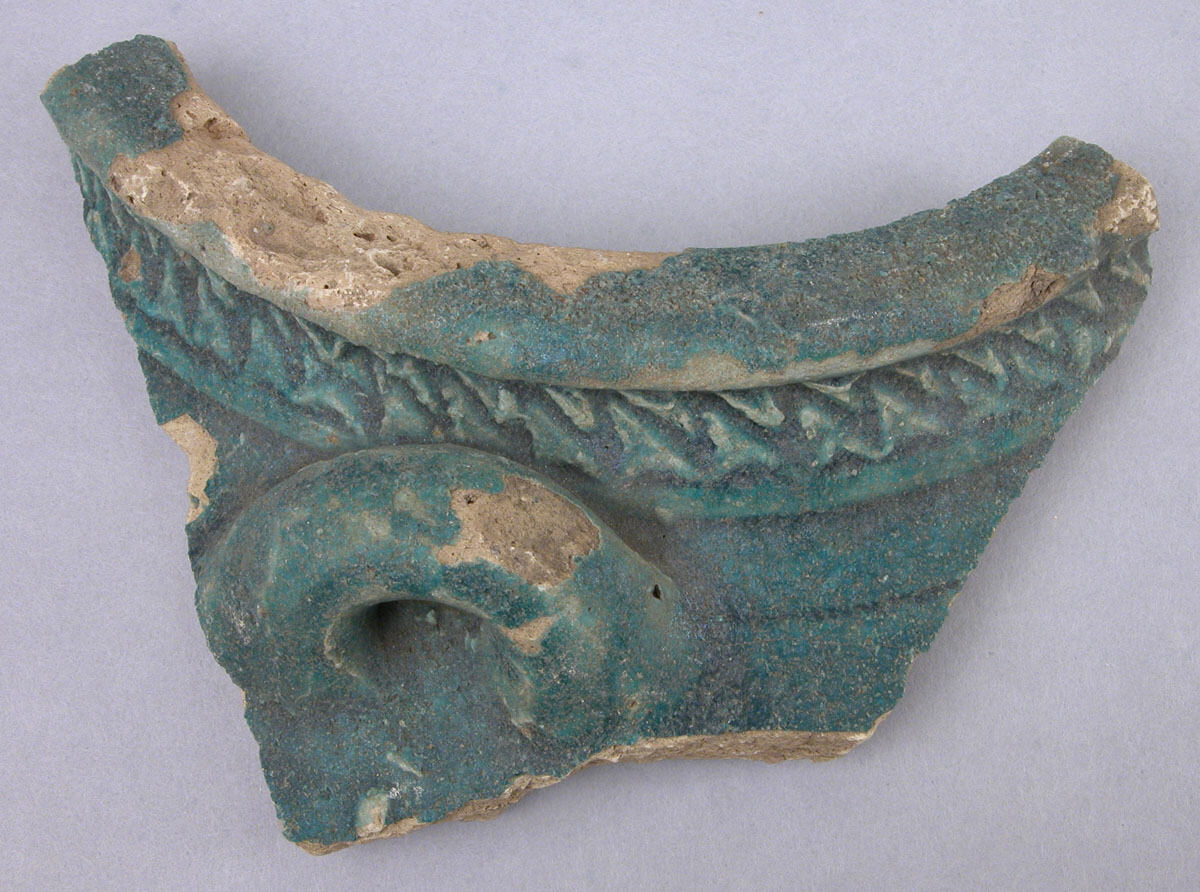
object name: fragment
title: Ceramic Fragment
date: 601-800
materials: earthenware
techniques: glazing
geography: iraq